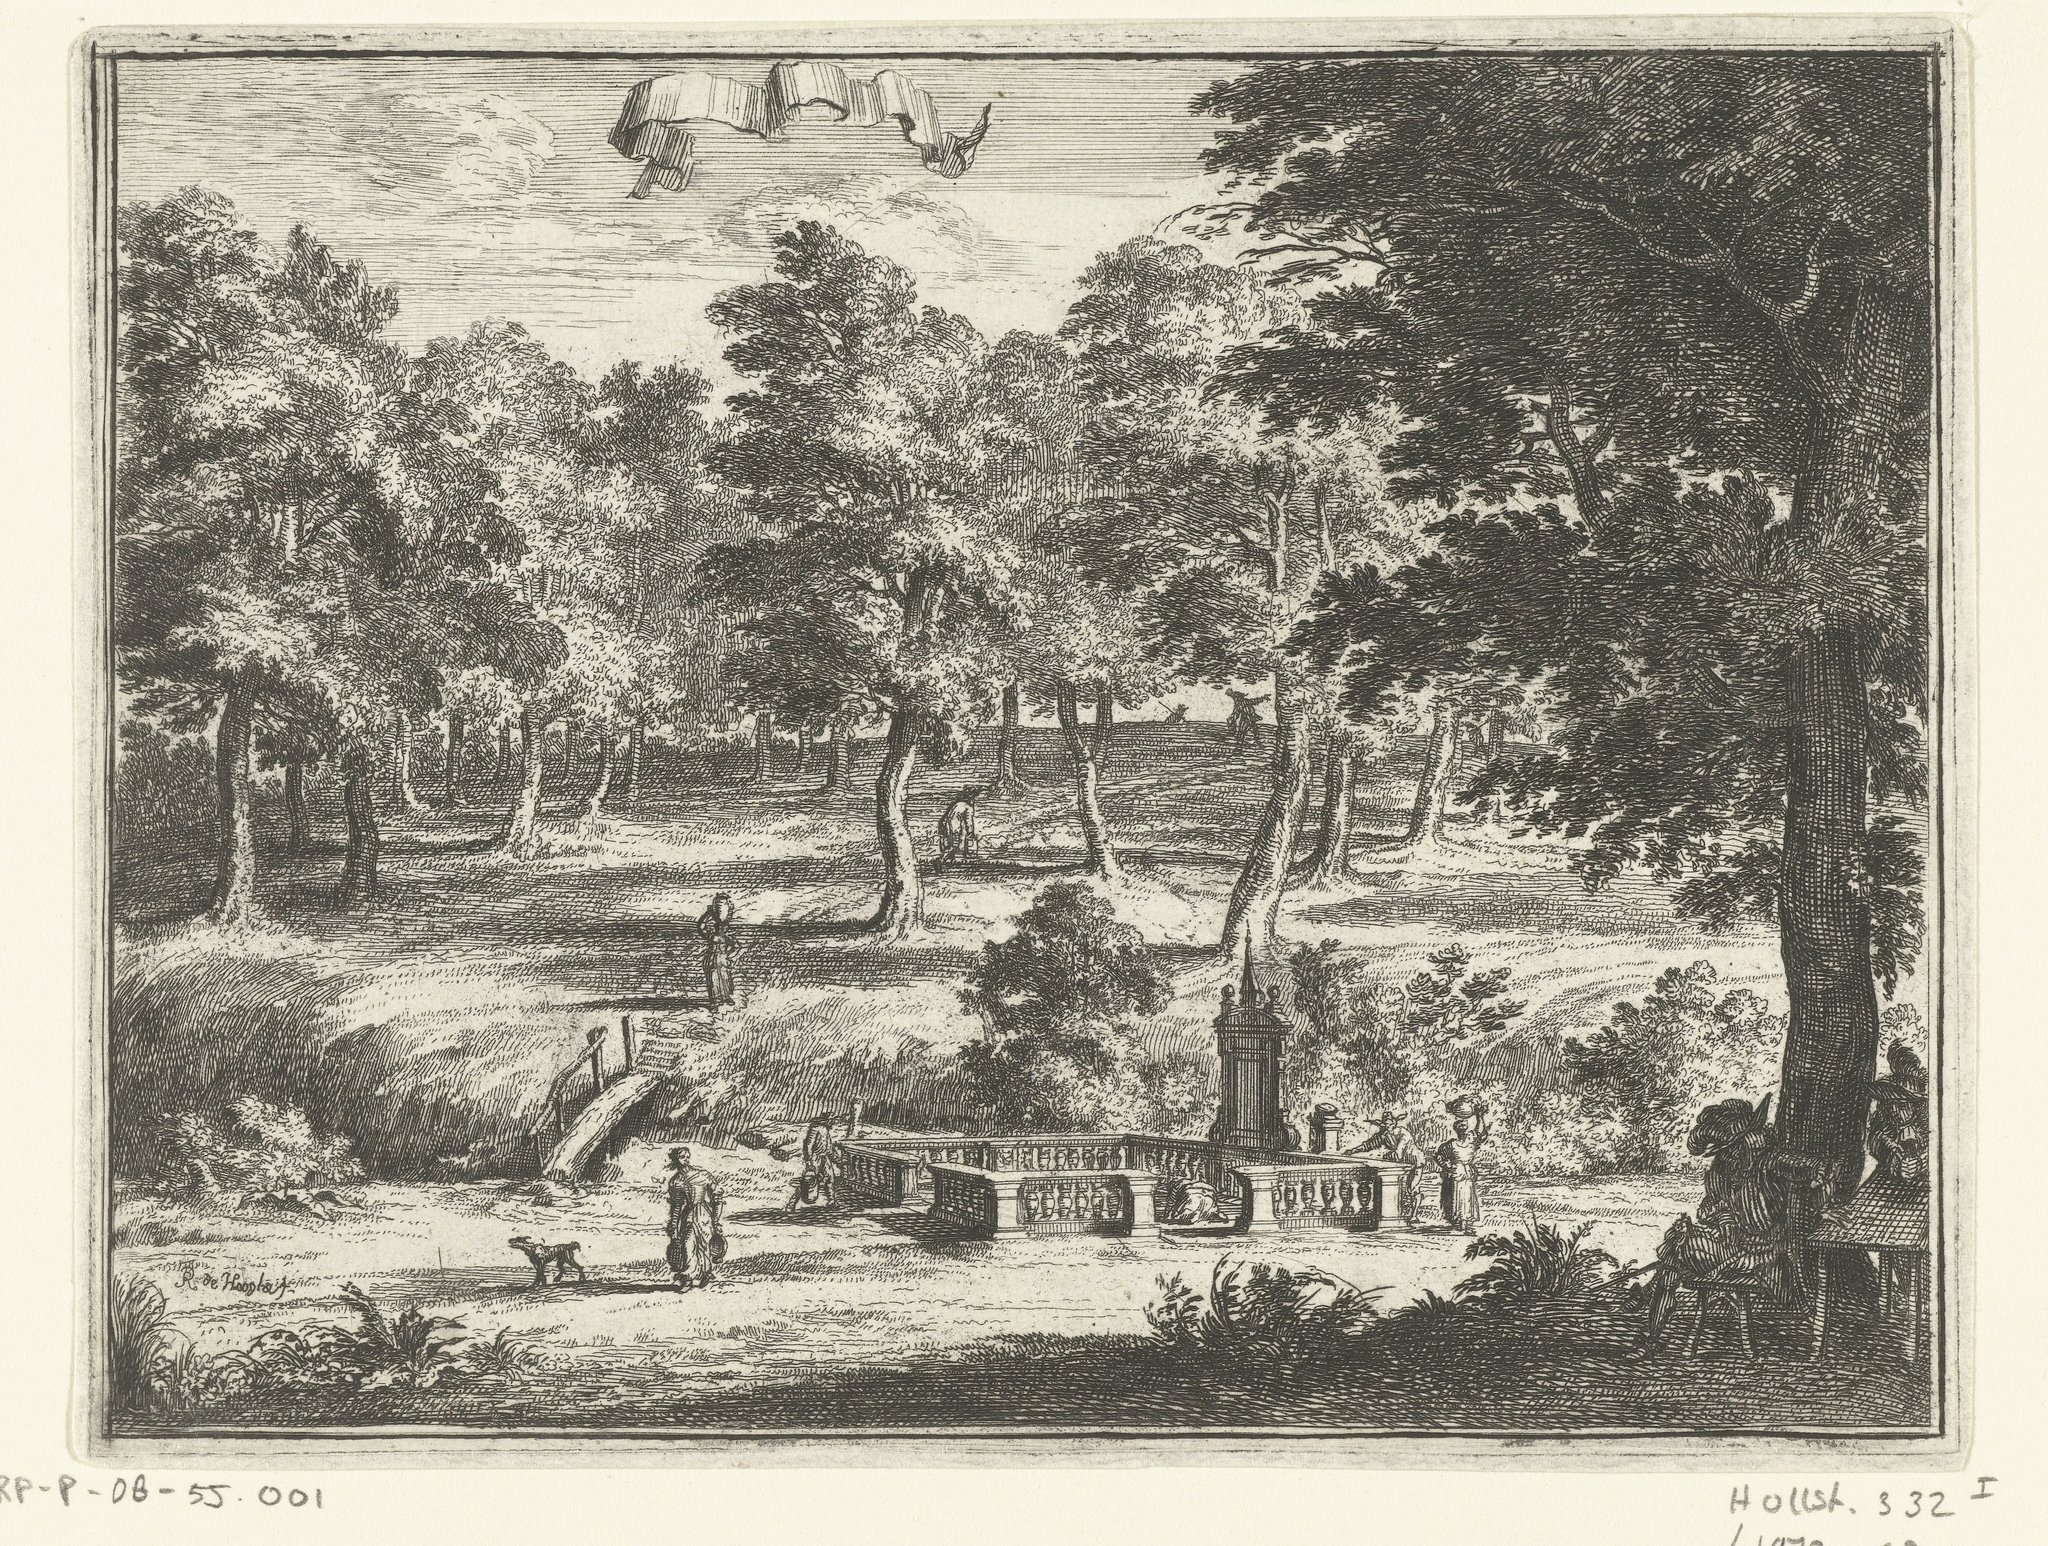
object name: book illustration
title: Landschap met de bron 'Acidula Smechtana'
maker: romeyn de hooghe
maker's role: draughtsman, goldsmith, painter, print maker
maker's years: 1645-1708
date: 1672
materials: paper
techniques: etching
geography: netherlands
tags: well, germany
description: Landschap met de bron 'Acidula Smechtana', met lege banderol in de lucht.